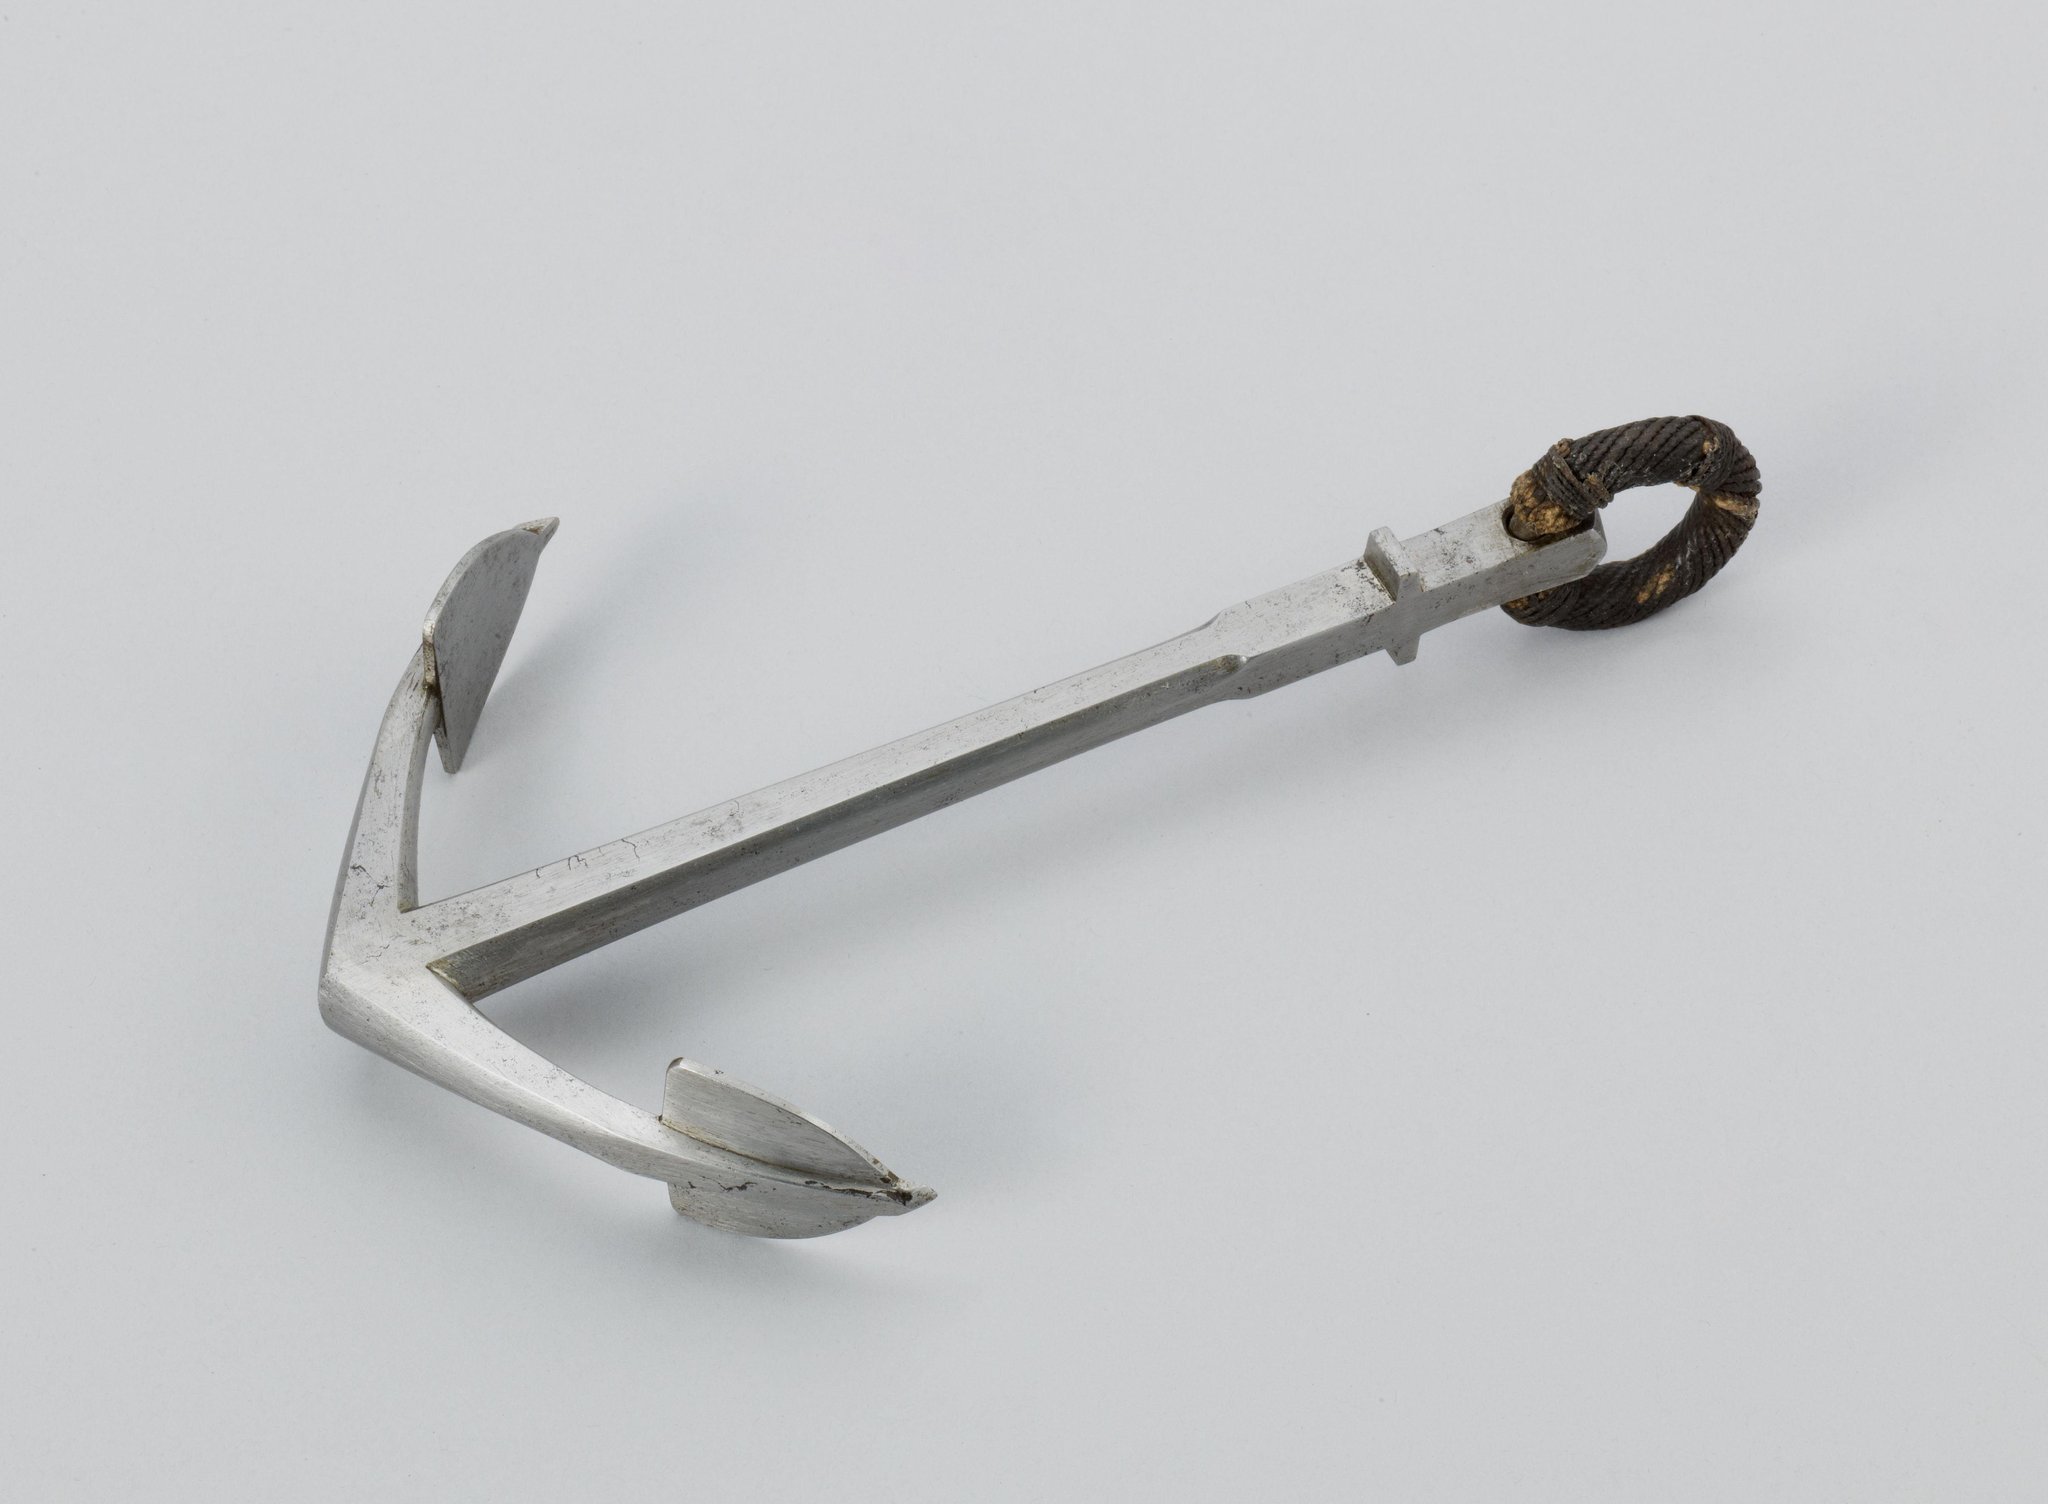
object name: instruction model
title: Model of an Anchor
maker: Anonymous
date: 1858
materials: brass, iron, fiber, wood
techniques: tarring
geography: netherlands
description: Model van een anker, bestaande uit een schacht met een gebogen arm met ankerhanden op de uiteinden. IJzeren ankerring met ankerroering van geteerd touw. De schacht is zwaarder, de hoek tussen schacht en armen kleiner en de handen zijn breder dan gewoonlijk. De ankerstok ontbreekt. Schaal 1:10 (schatting).